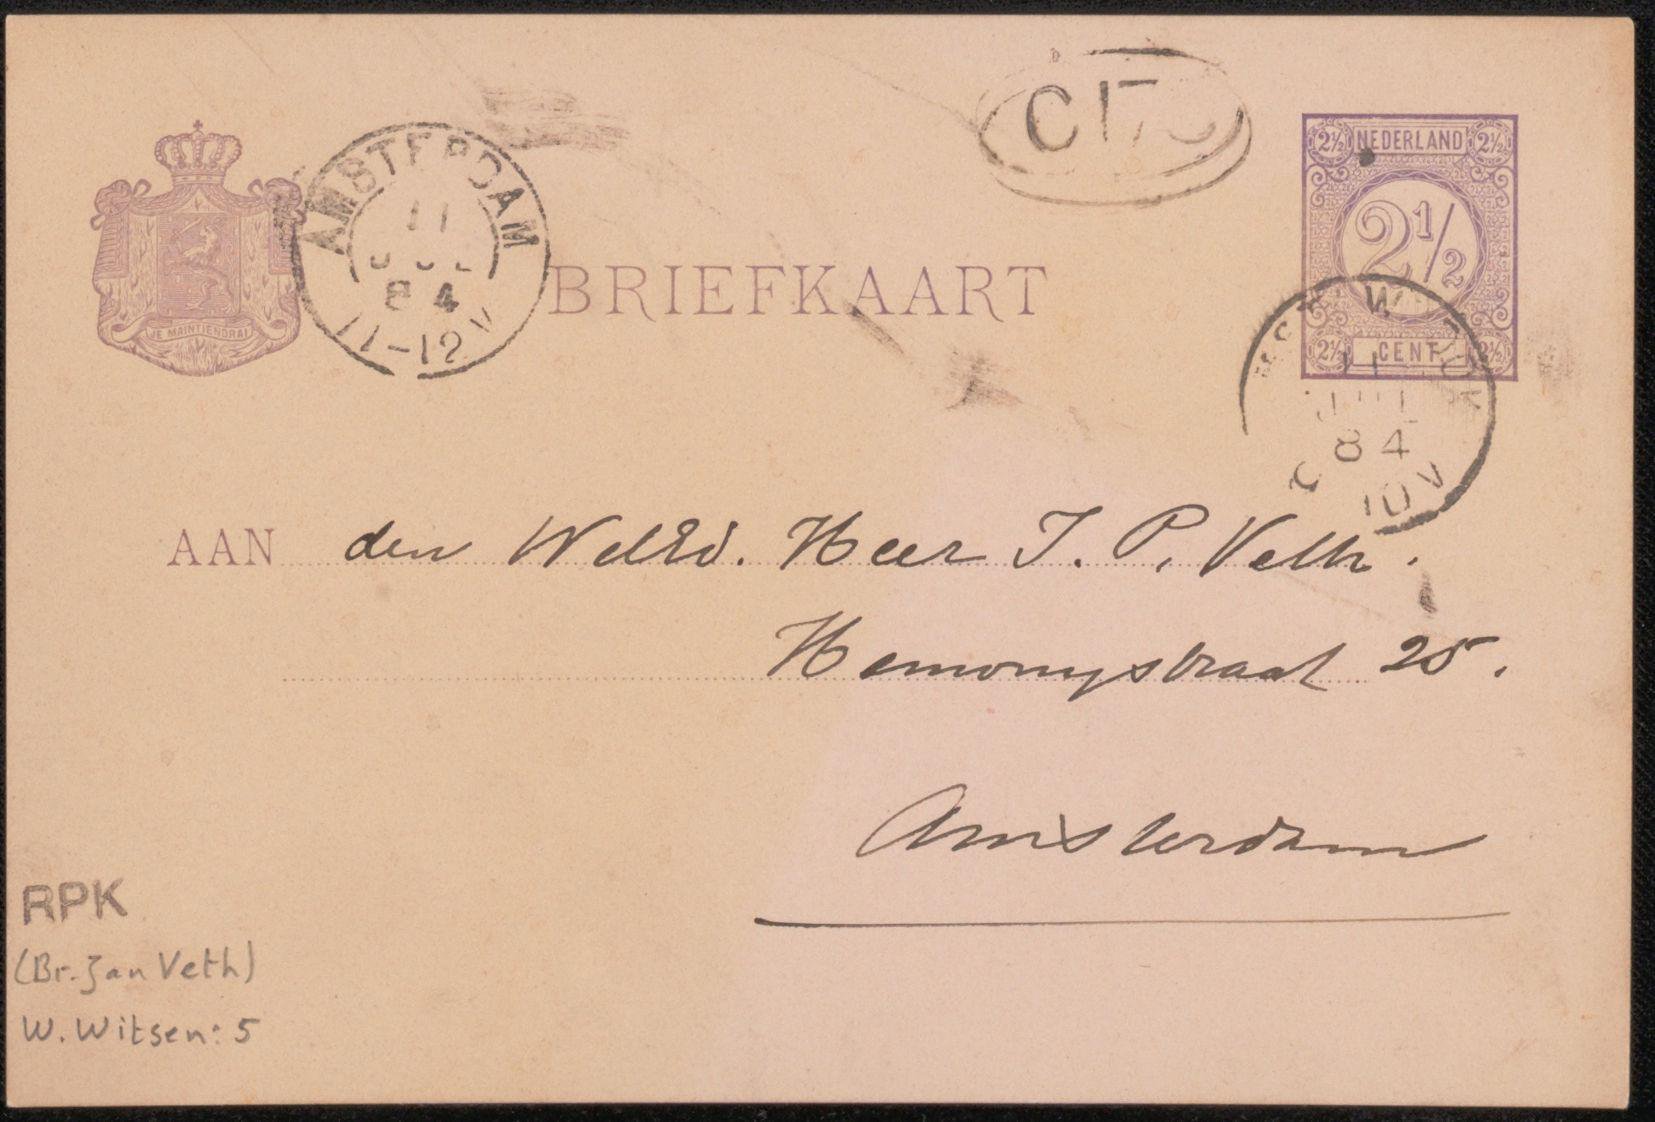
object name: postcard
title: Briefkaart aan Jan Veth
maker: willem witsen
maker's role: draughtsman, painter, print maker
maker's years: 1860-1923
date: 1884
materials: cardboard, ink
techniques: pen, writing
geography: ewijkshoeve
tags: dordrecht, designer, jan veth, painting (including book-illumination, miniature-painting), leiden, amsterdam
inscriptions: collector's mark: ‘RPK’